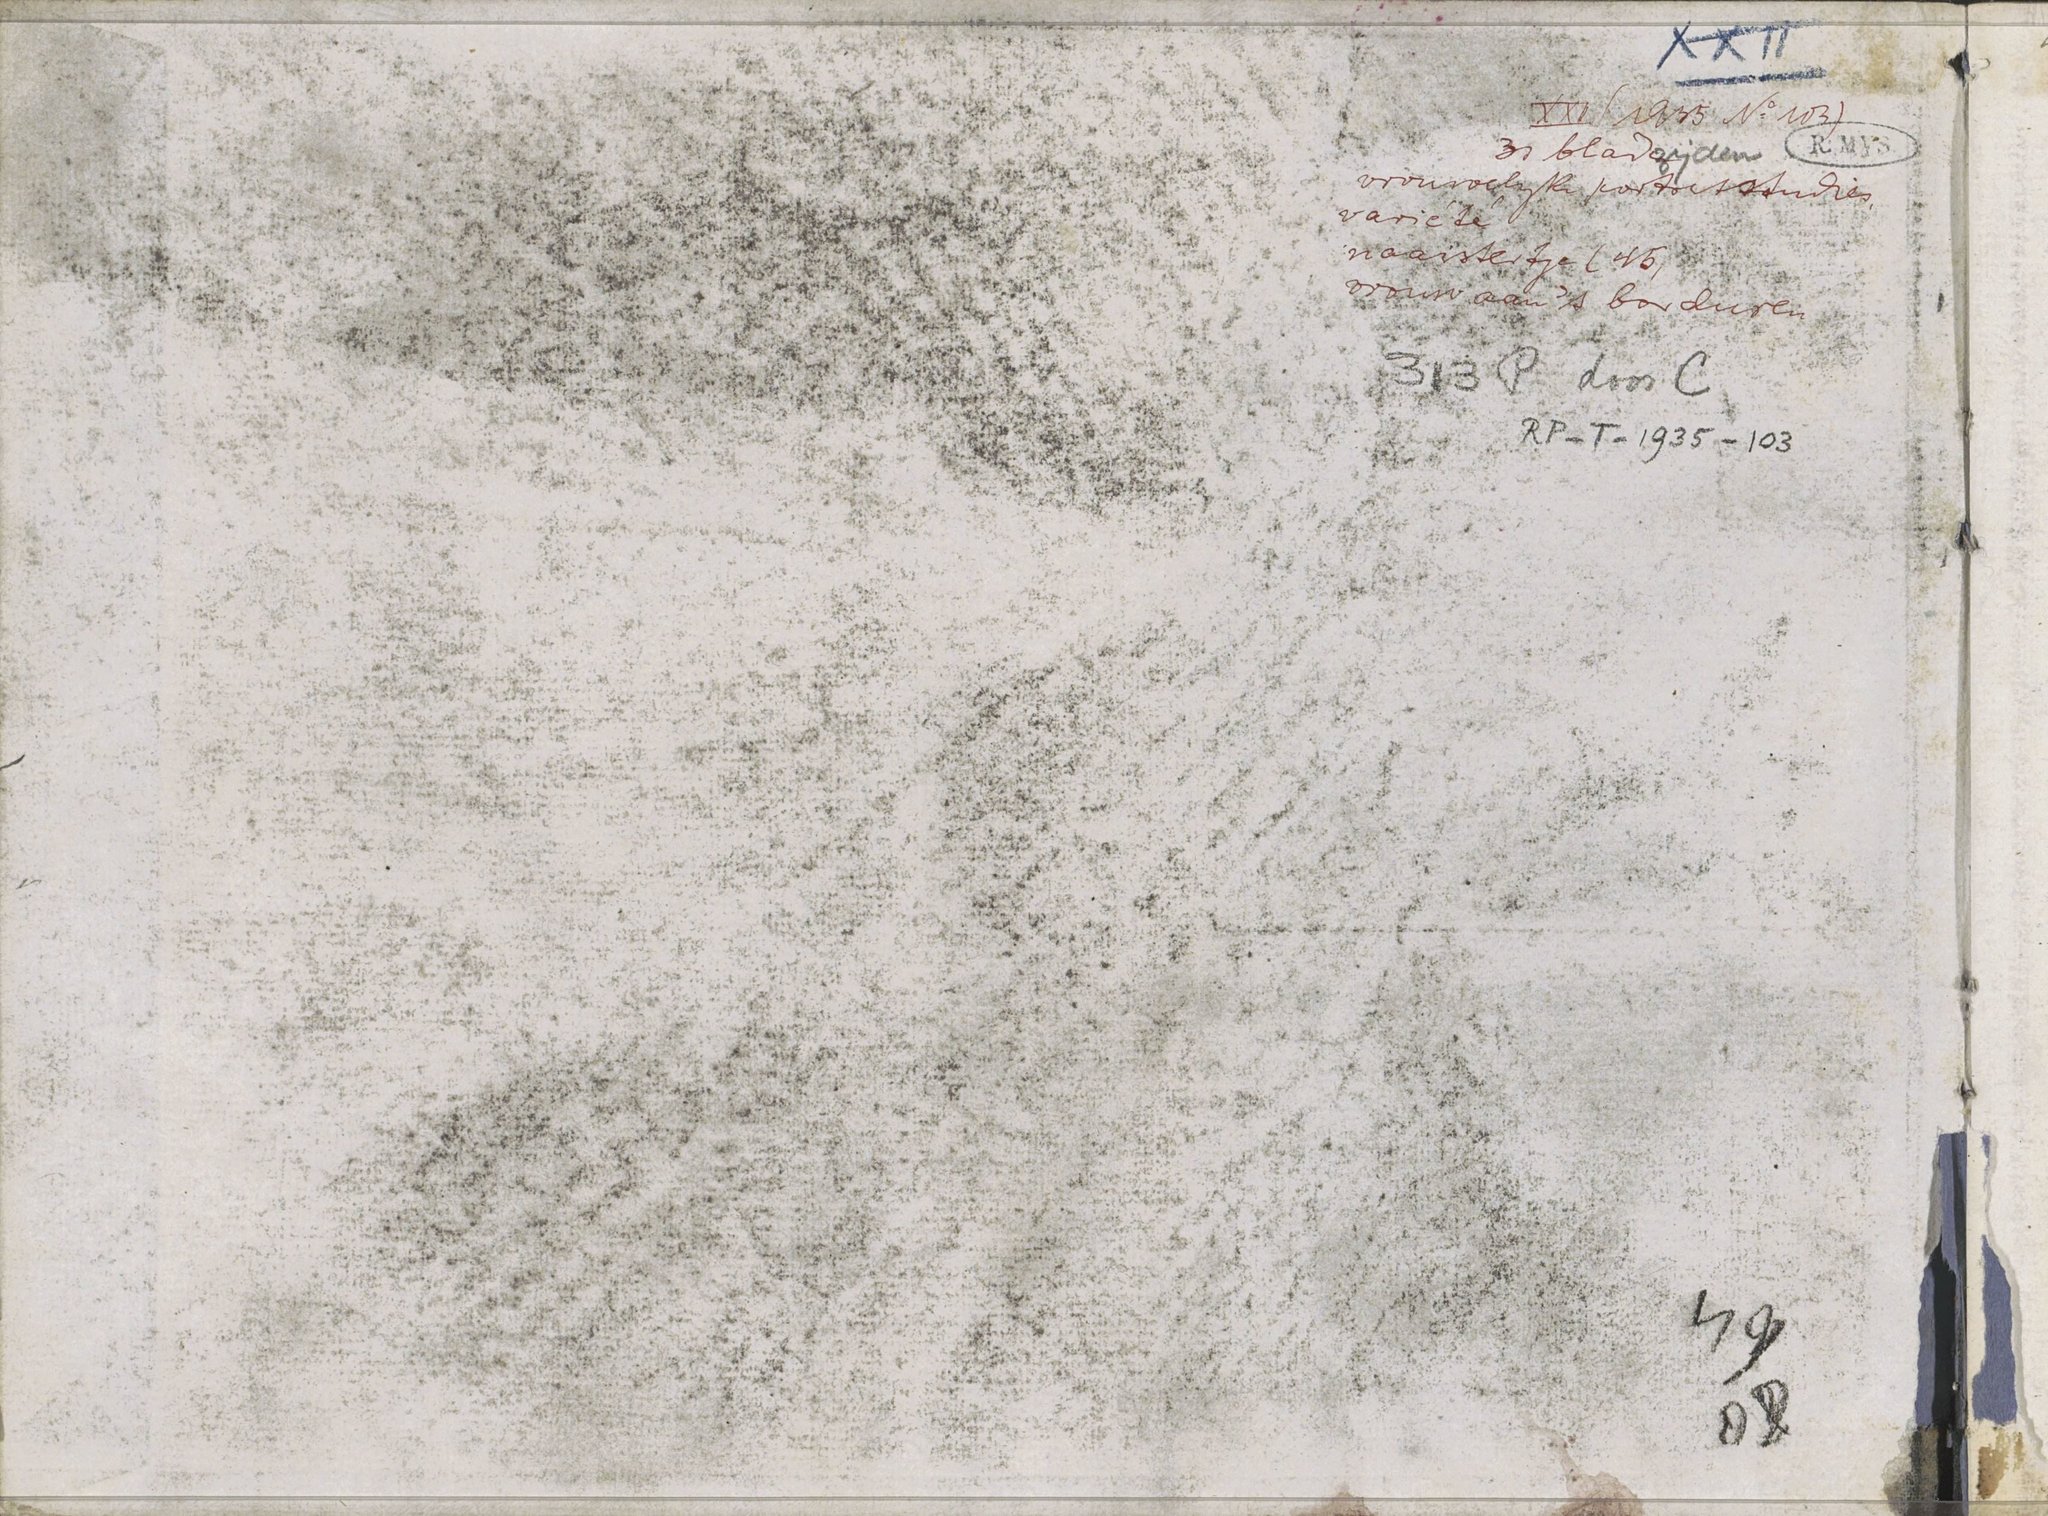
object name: endleaf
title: Annotatie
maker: isaac israels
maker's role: draughtsman, painter, print maker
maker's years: 1865-1934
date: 1875-1934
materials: chalk, paper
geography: the hague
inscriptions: number: ‘80 / 64’, collector's mark: Lugt 2228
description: Schutblad A, voorste schutblad, uit schetsboek XXII met 30 bladen.